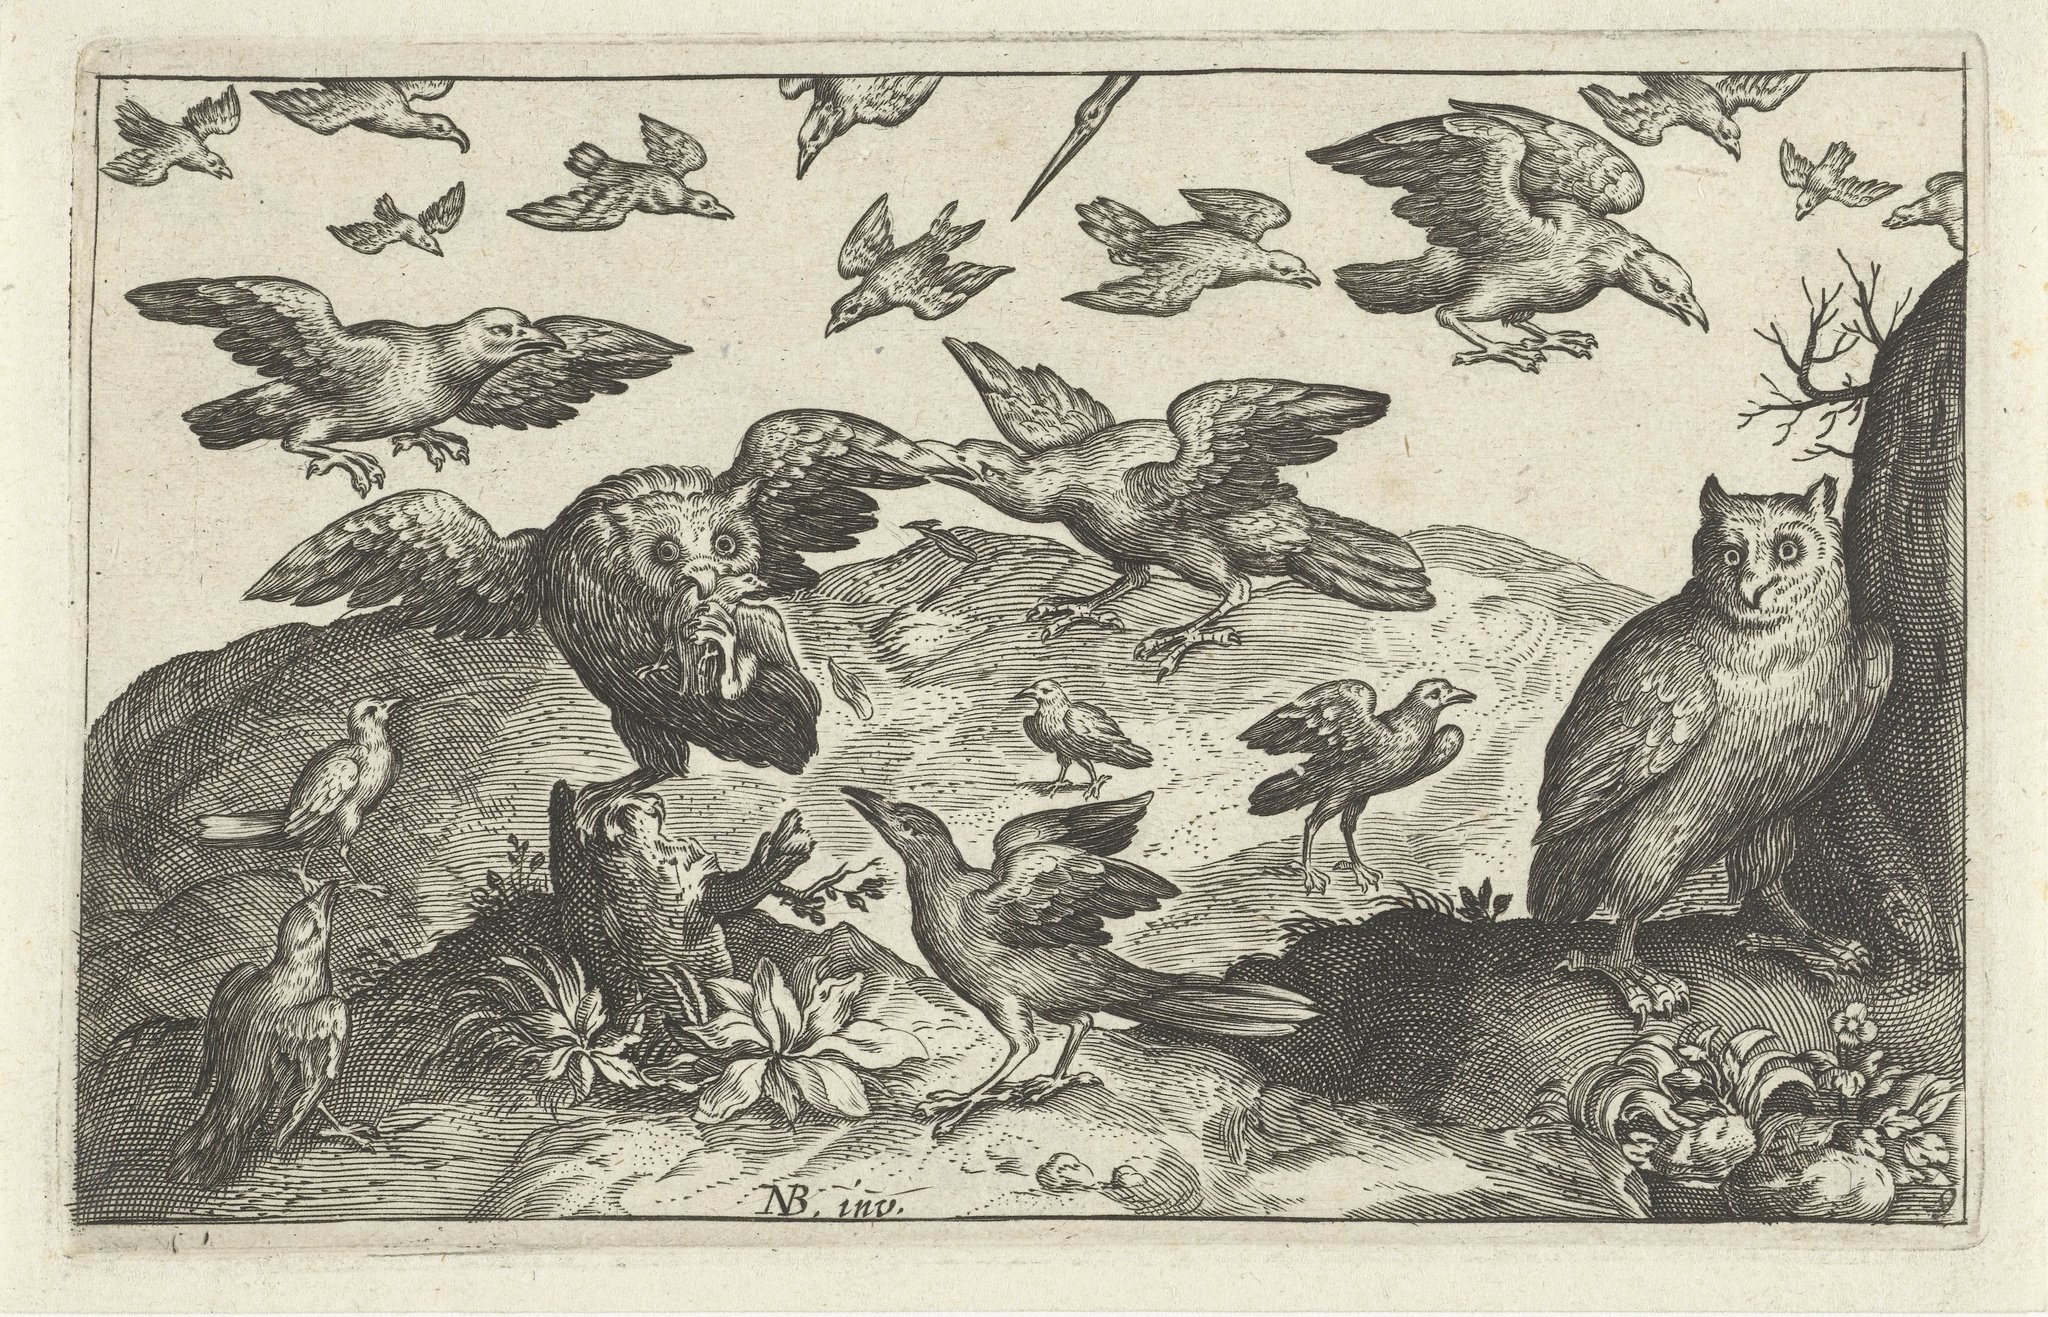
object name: print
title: Uil met prooi belaagd door andere vogels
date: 1594-1644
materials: paper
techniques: engraving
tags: song-birds: crow, owls, animals (+ animal with prey)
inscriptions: collector's mark: Lugt 2228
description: Kopie in spiegelbeeld naar prent van Nicolaes de Bruyn. Prent uit serie van twaalf prenten met vogels en insecten. Bij Hollstein zijn bladen van een andere serie prenten afgebeeld, zie De Groot 1988, p. 37.